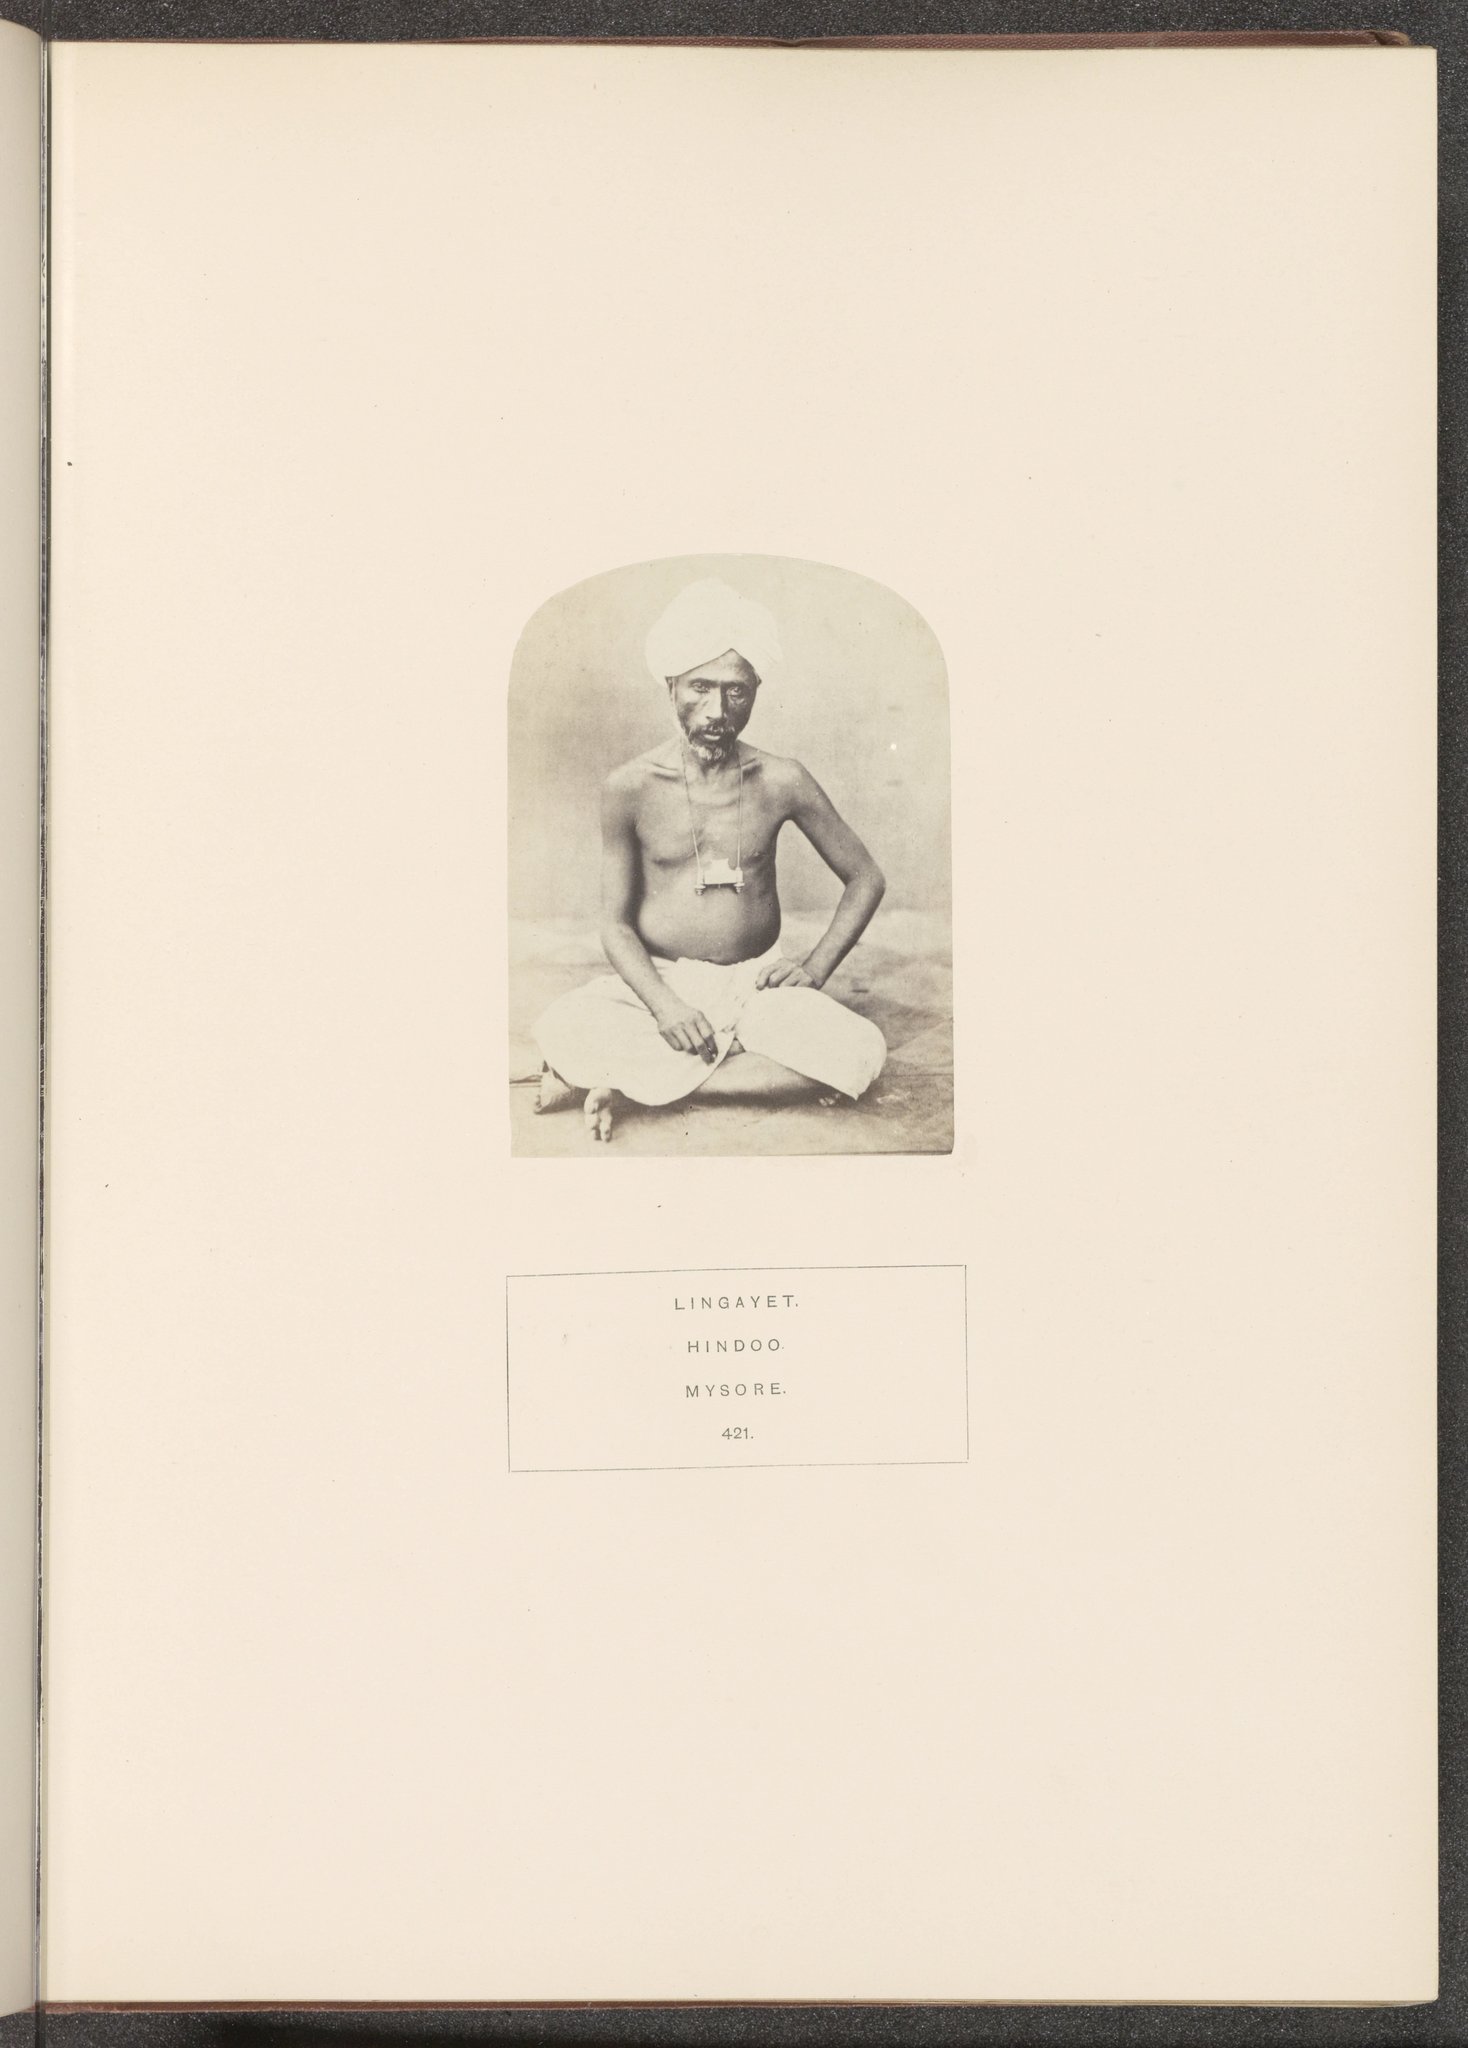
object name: page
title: Portrait of an unknown man from the Lingayat community of Mysore, Karnataka, India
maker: Anonymous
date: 1865-1875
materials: photographic support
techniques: albumen print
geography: mysore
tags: human races; peoples; nationalities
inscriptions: number: ‘421.’, inscription: ‘LINGAYET./ HINDOO./ MYSORE.’